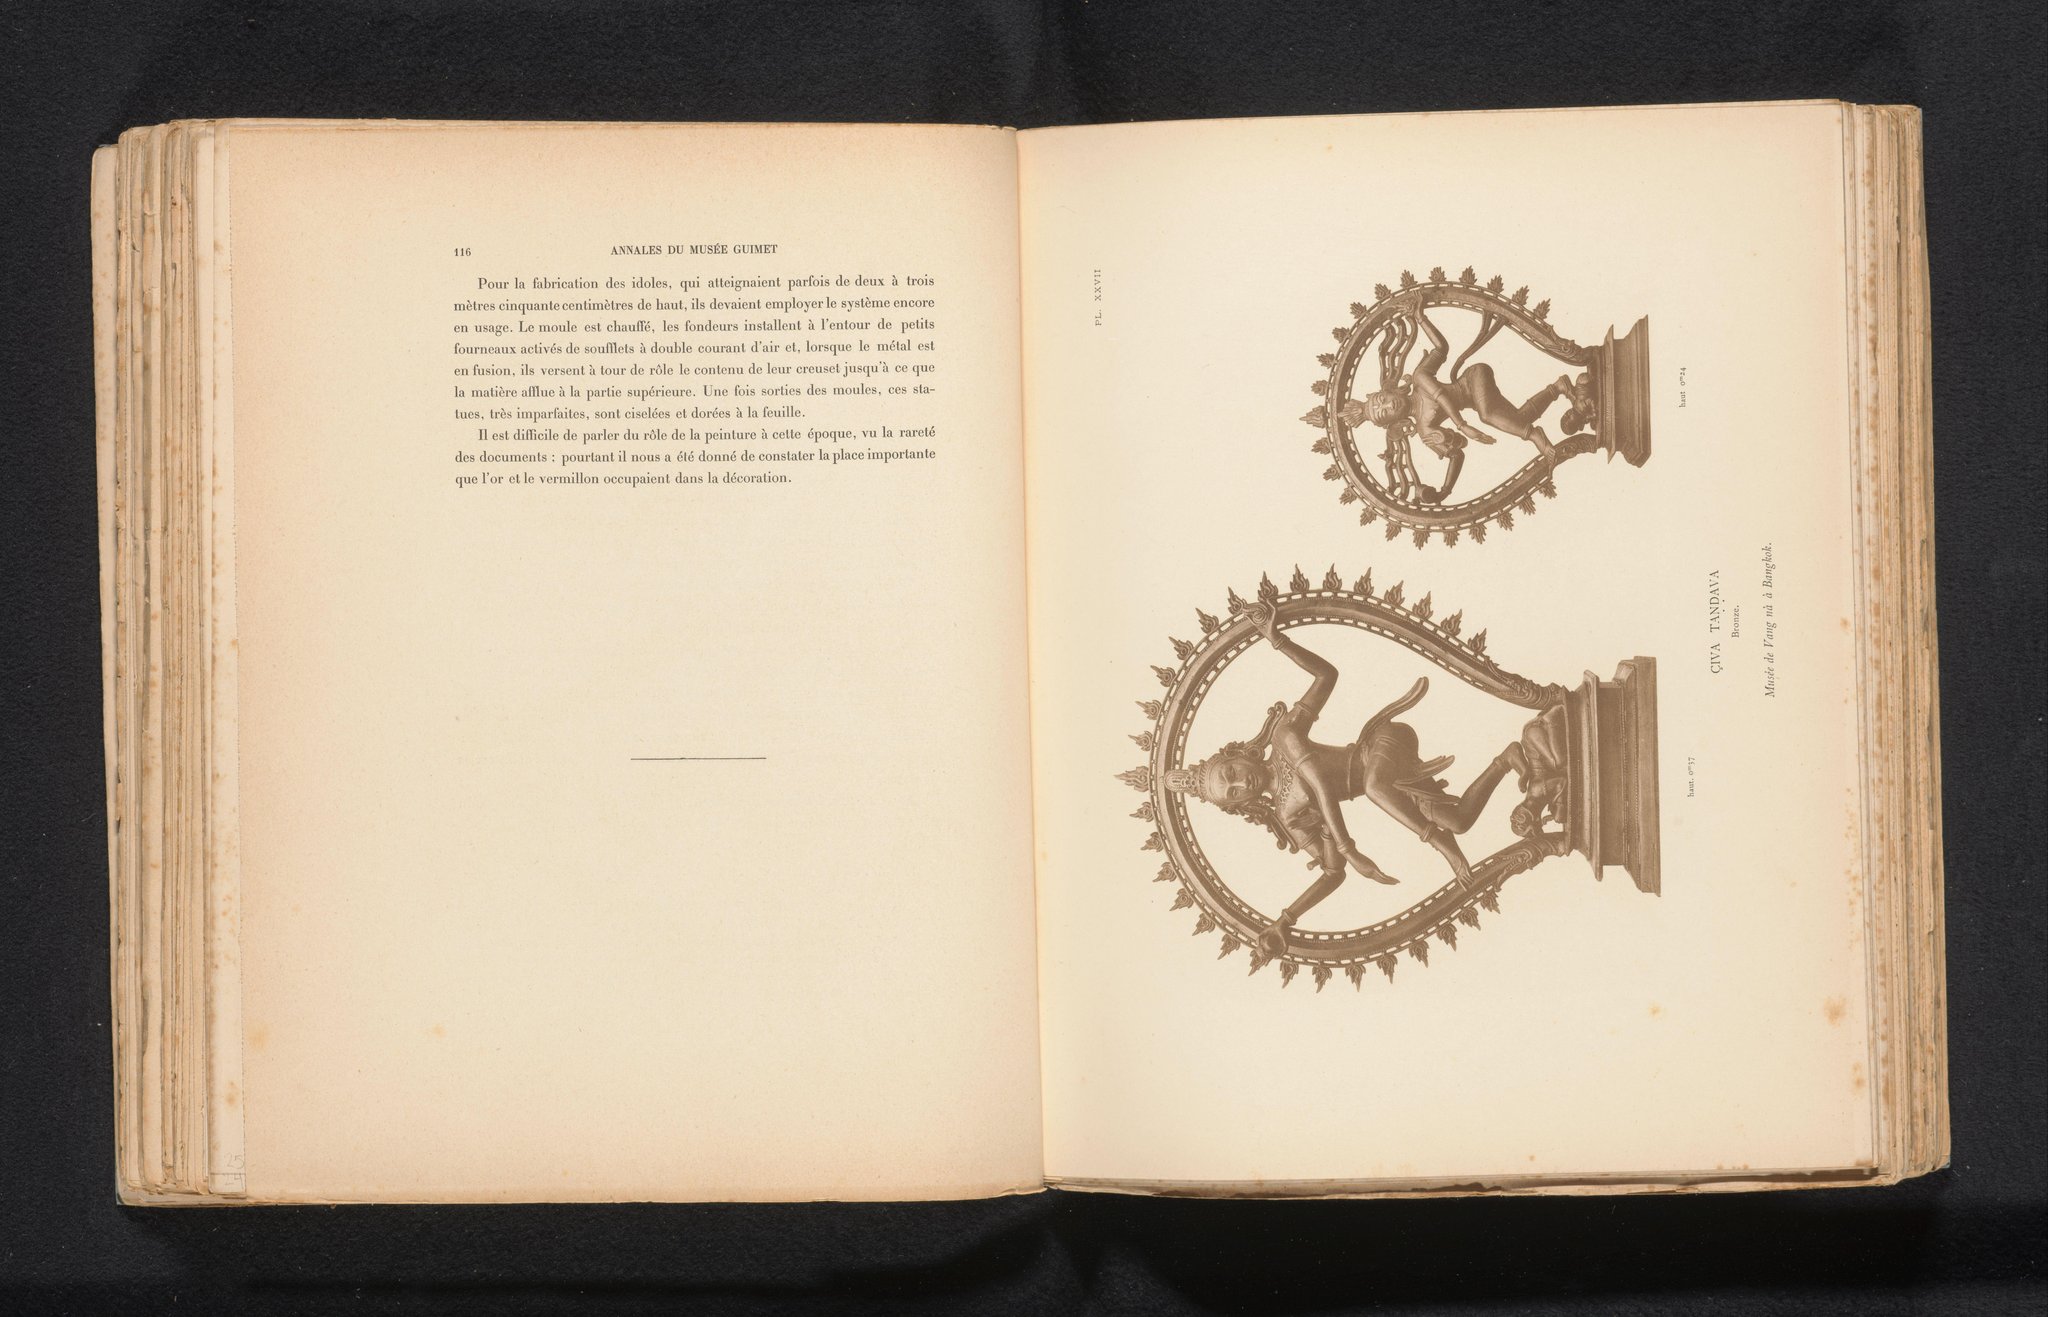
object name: photomechanical print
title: Civa Taņdava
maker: Anonymous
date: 1890-1895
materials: paper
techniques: photograph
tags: representations ~ gods, demi-gods, heroes, etc. (hinduism, buddhism, jainism)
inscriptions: inscription: ‘Pl. XXVII’, inscription: ‘Bronze /Musée de Vang nà à Bangkok’, collector's mark: ‘Société d'Emulation de l'Ain/ Bourg/ Bibliothèque’